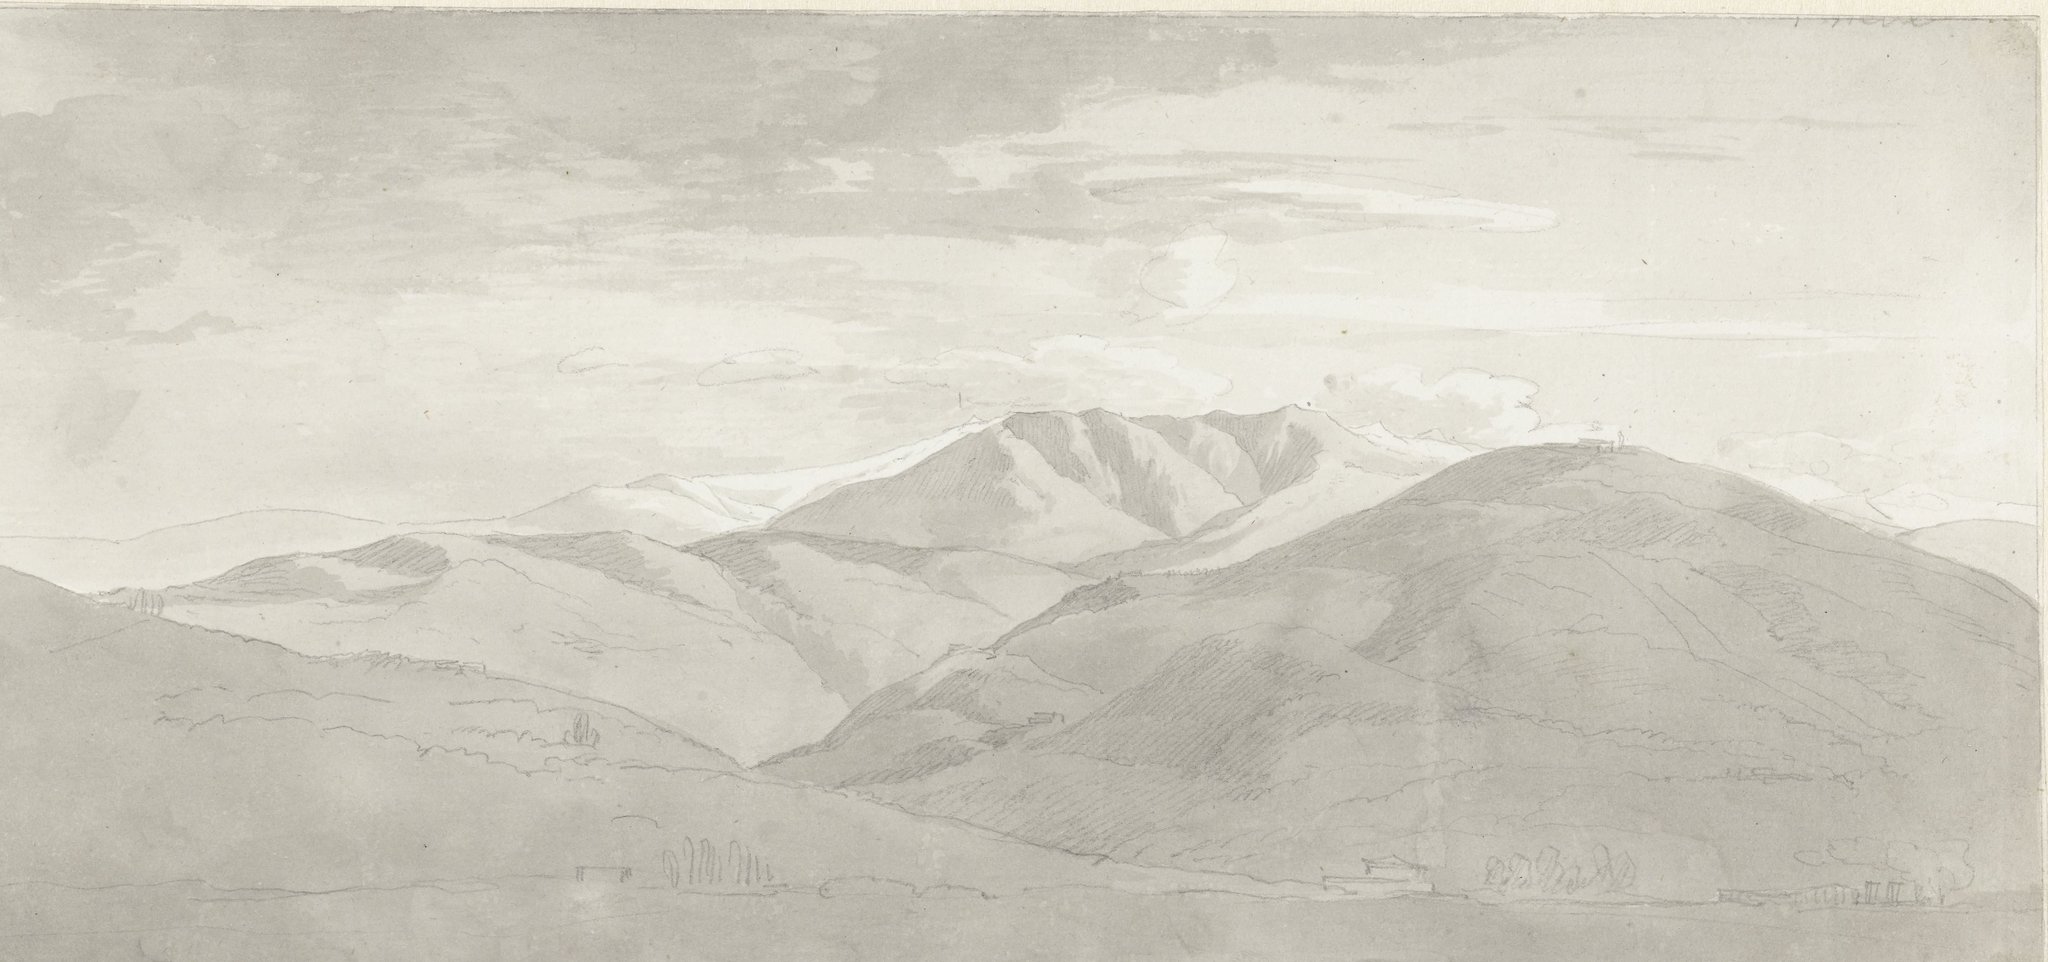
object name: drawing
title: Berglandschap in Italië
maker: hendrik voogd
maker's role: draughtsman, painter, print maker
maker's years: 1768-1839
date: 1788-1839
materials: paper, pencil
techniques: brush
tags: mountains, italy